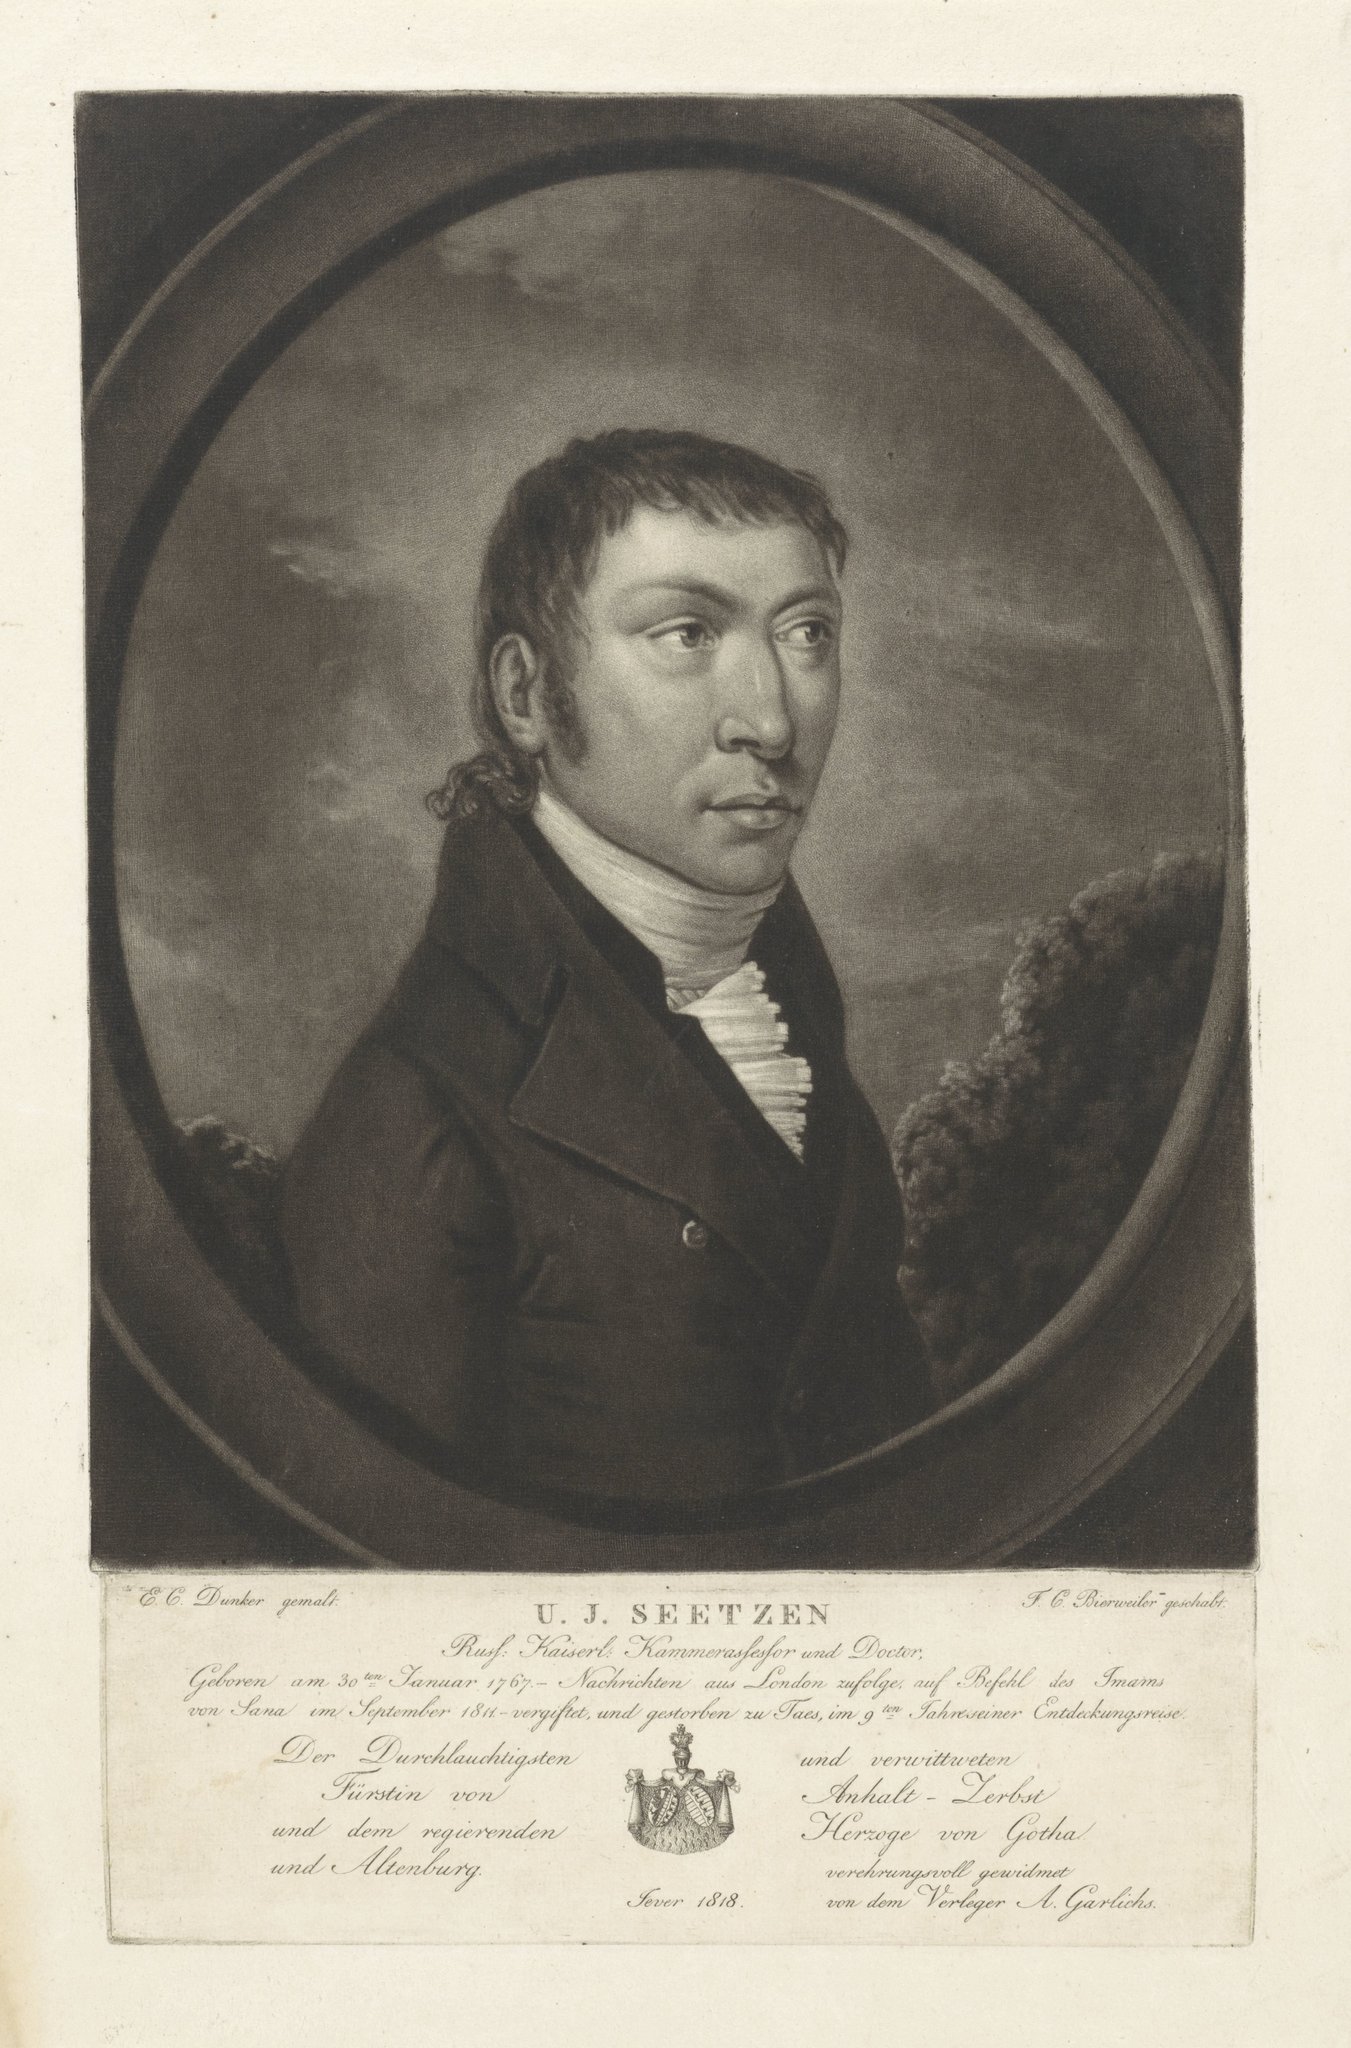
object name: print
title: Portret van Ulrich Jasper Seetzen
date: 1818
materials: paper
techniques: mezzotint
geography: jever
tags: sophiengroden, midden-oosten, arts, oriëntalist, ulrich jasper seetzen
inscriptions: collector's mark: Lugt 2228, collector's mark: Lugt 1337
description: Portret van de arts Ulrich Jasper Seetzen in zijn studeerkamer.